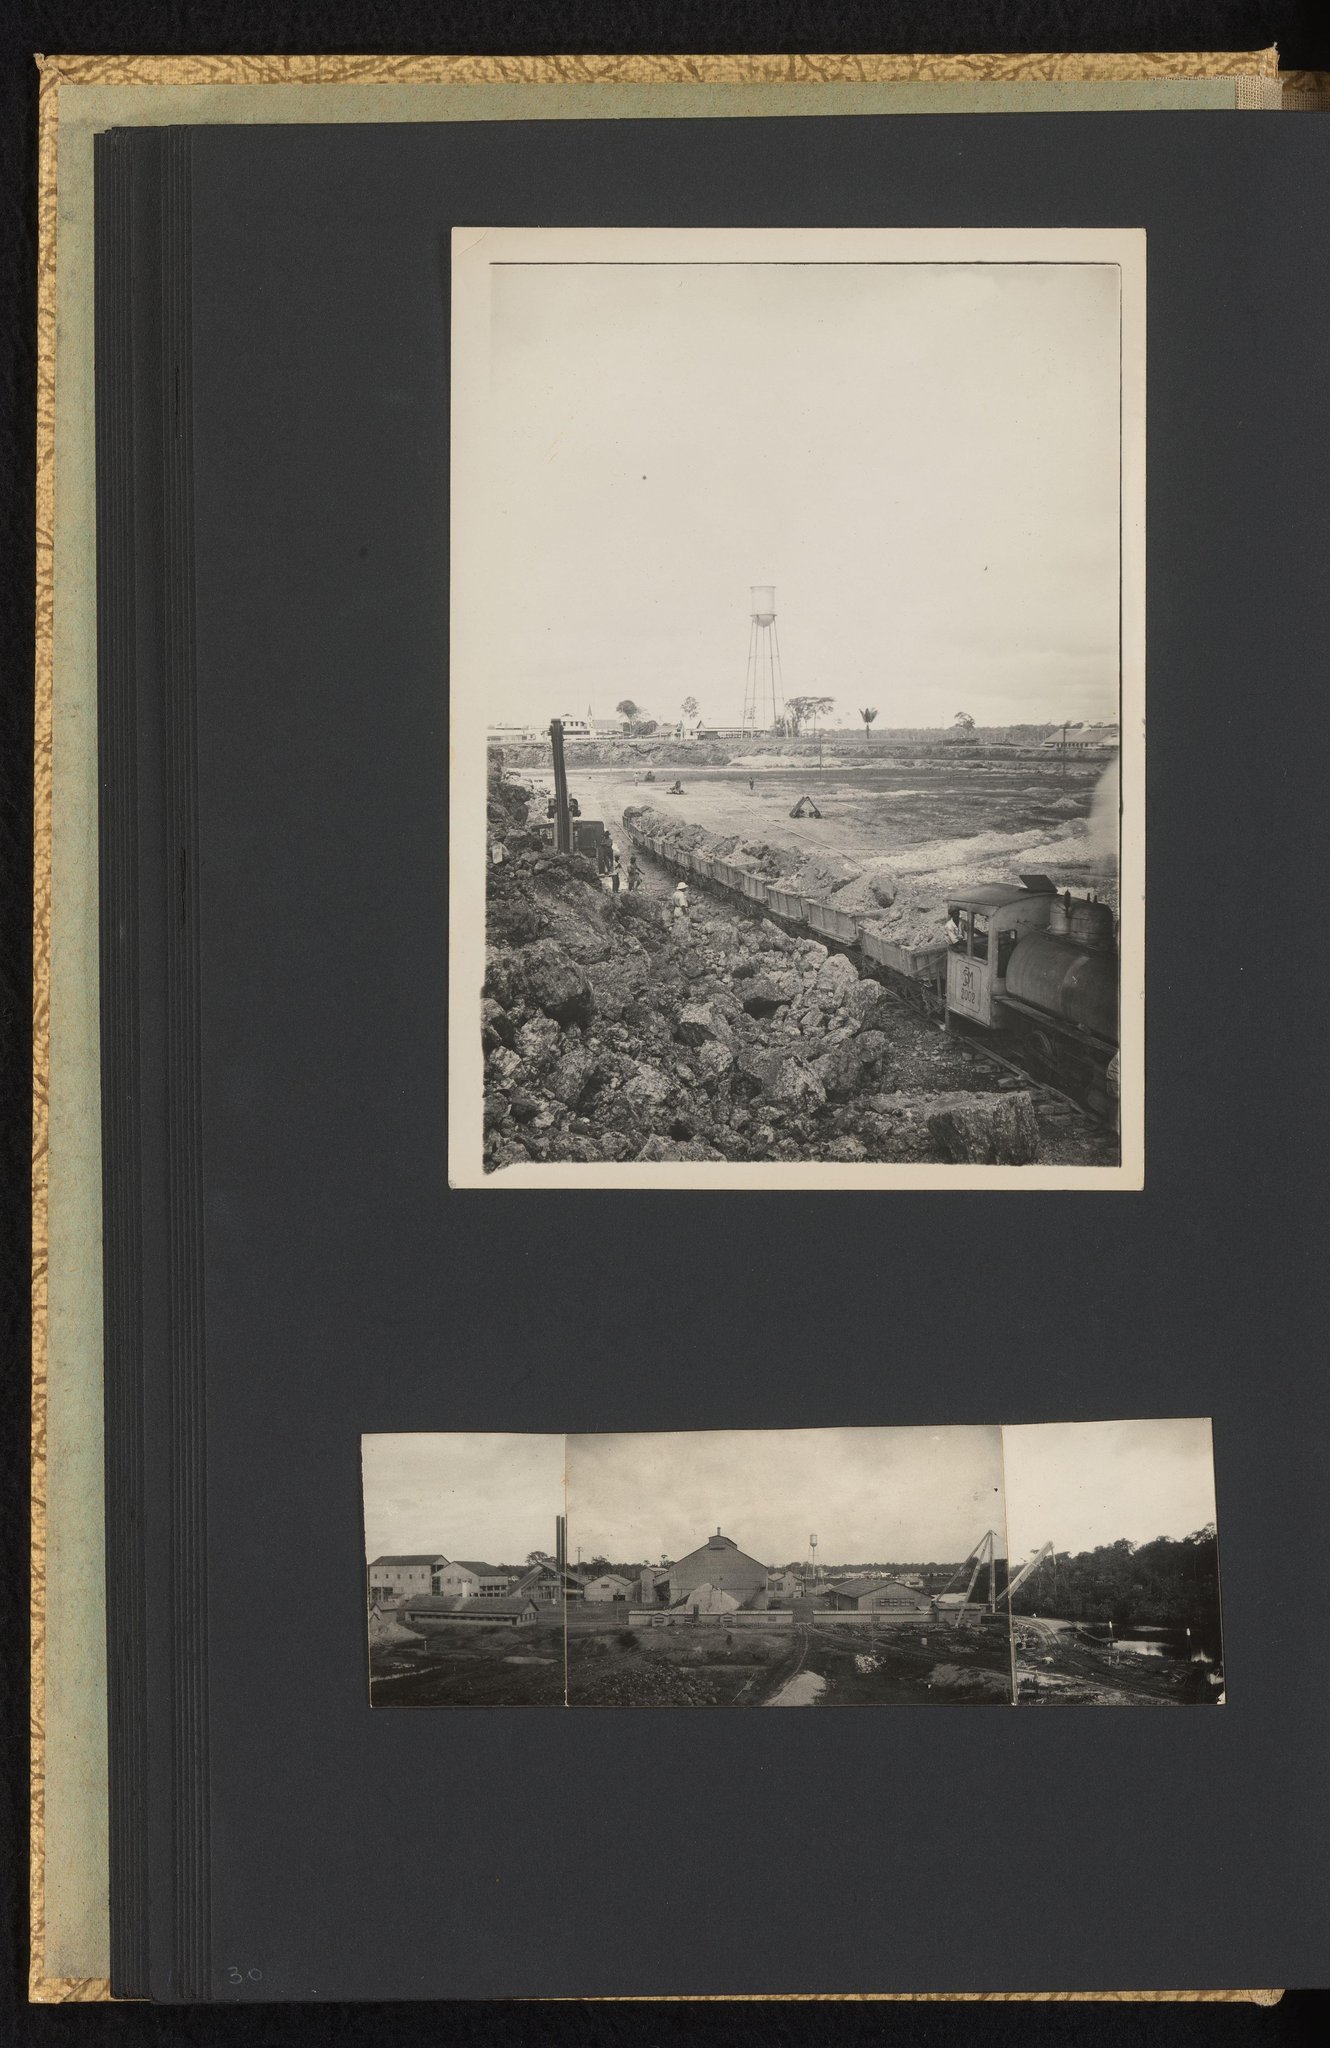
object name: album leaf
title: Bauxietwinning Suriname met arbeiders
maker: Anonymous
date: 1929-1930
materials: paper, photographic support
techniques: gelatin silver print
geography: suriname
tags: opencast mine; strip mining, exterior of industrial structures, factories, suriname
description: Albumblad met twee foto's van de bauxietwinning in Moengo, Suriname. Boven transport door trein met wagens met erts, onder een panoramafoto van het fabriekscomplex samengesteld uit drie aparte foto's. Onderdeel van het album van de familie Guilonard over de bauxietwinning in Moengo en Albina in Suriname in de jaren 1929-1930.